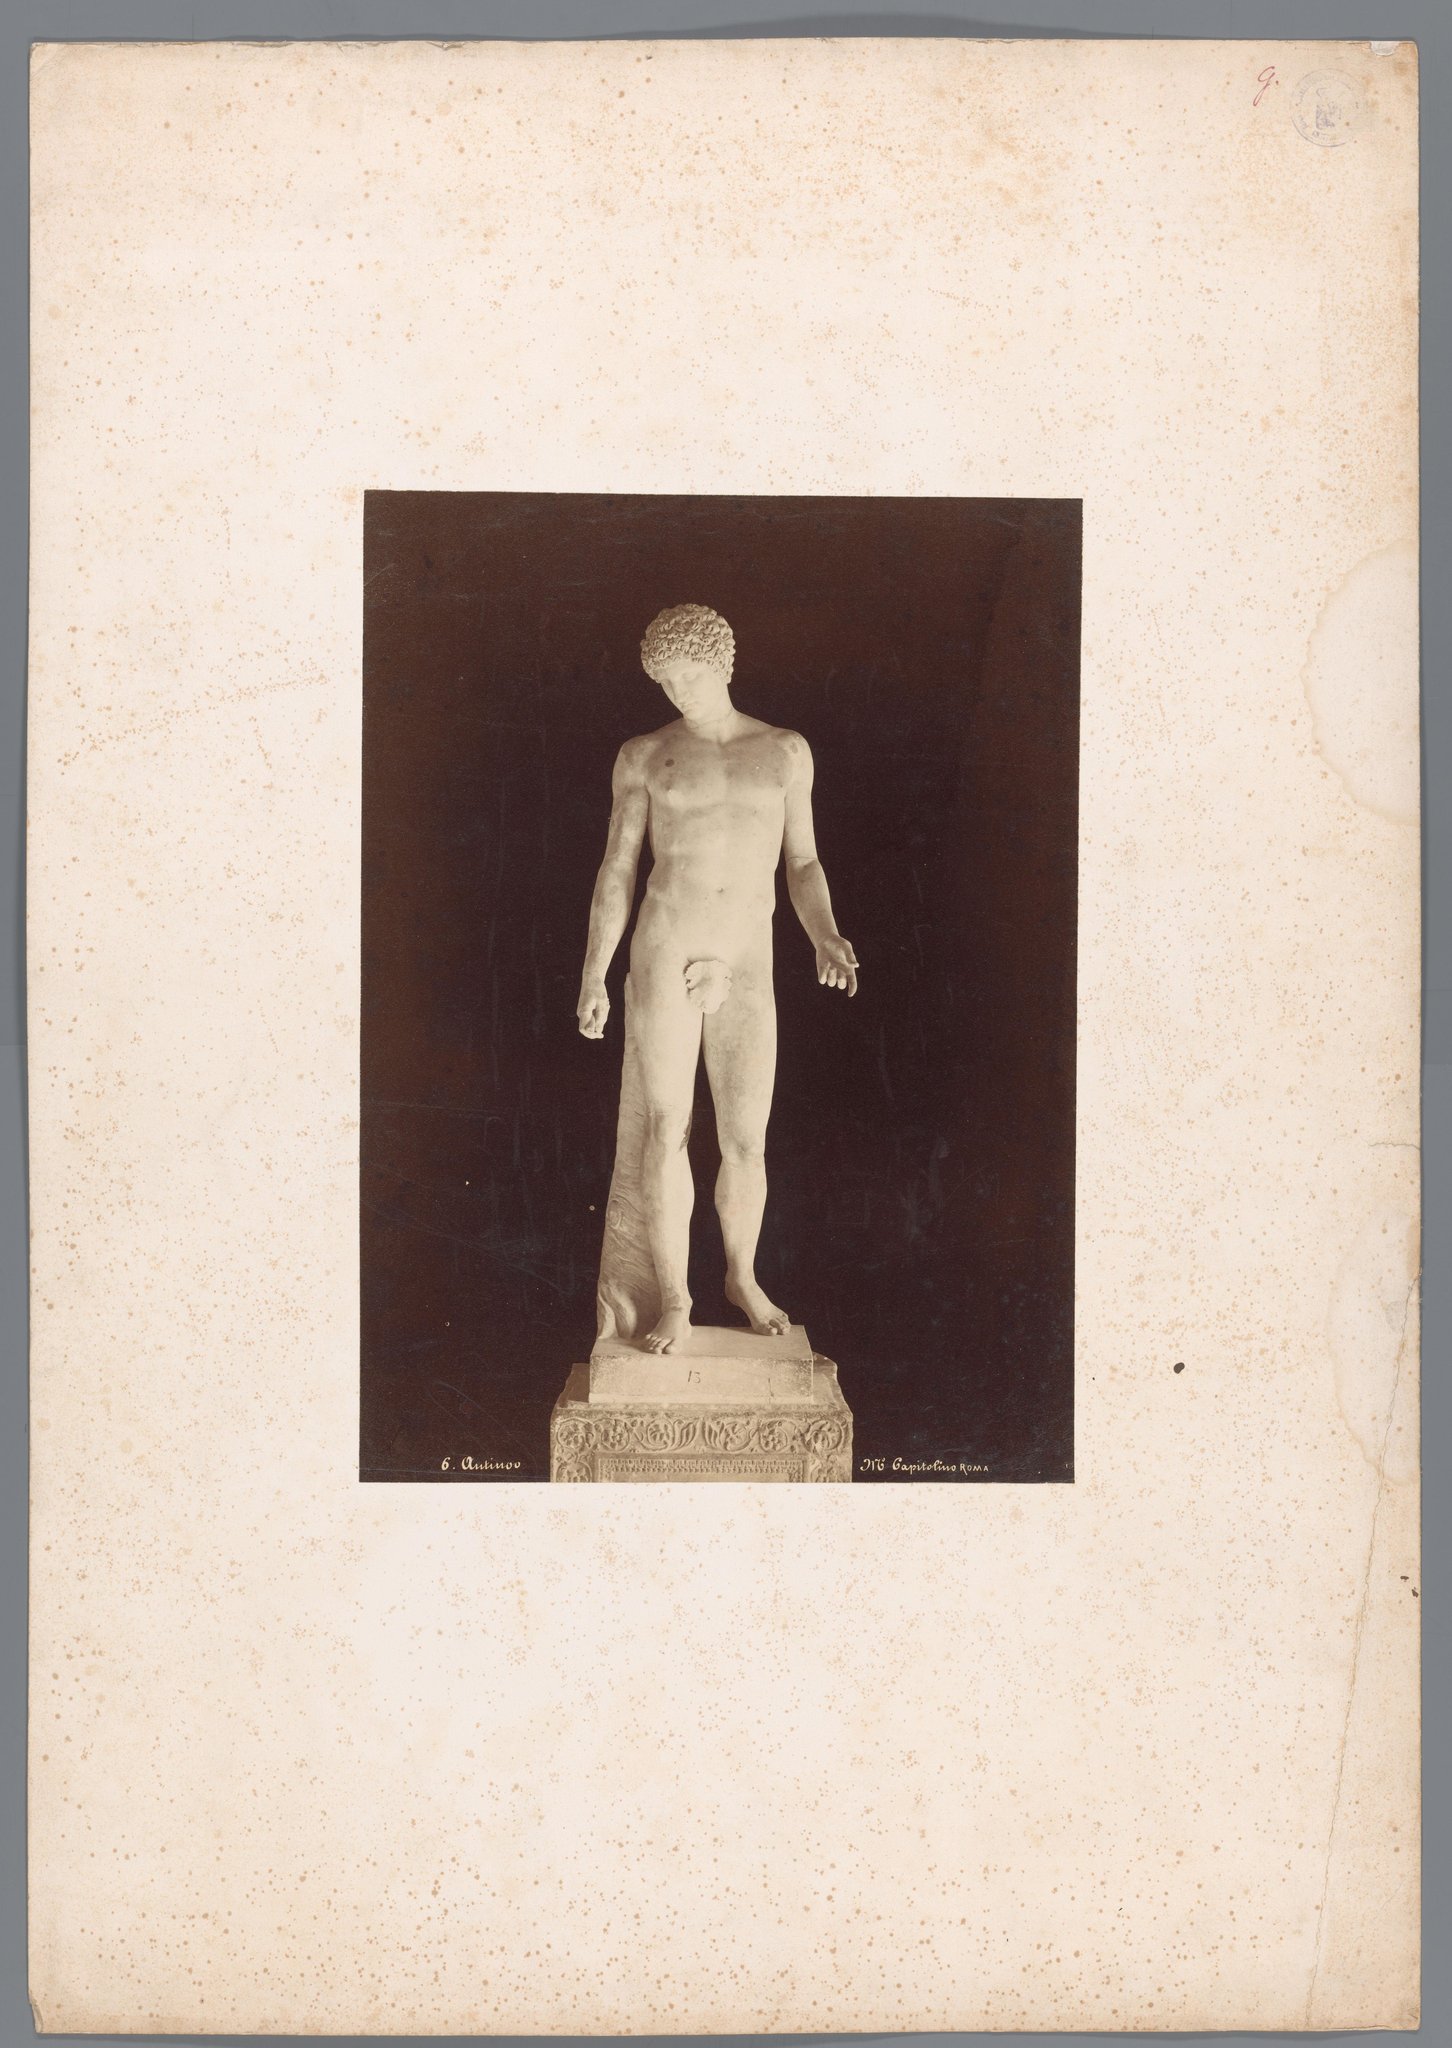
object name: photograph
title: Beeld van Antinoüs uit de Vaticaanse Musea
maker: Anonymous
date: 1880-1900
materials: cardboard, paper, photographic support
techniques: albumen print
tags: antinoüs, vaticaanse musea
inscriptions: : ‘G’, : ‘6. Antinoo Mo Vaticano ROMA’, stamp